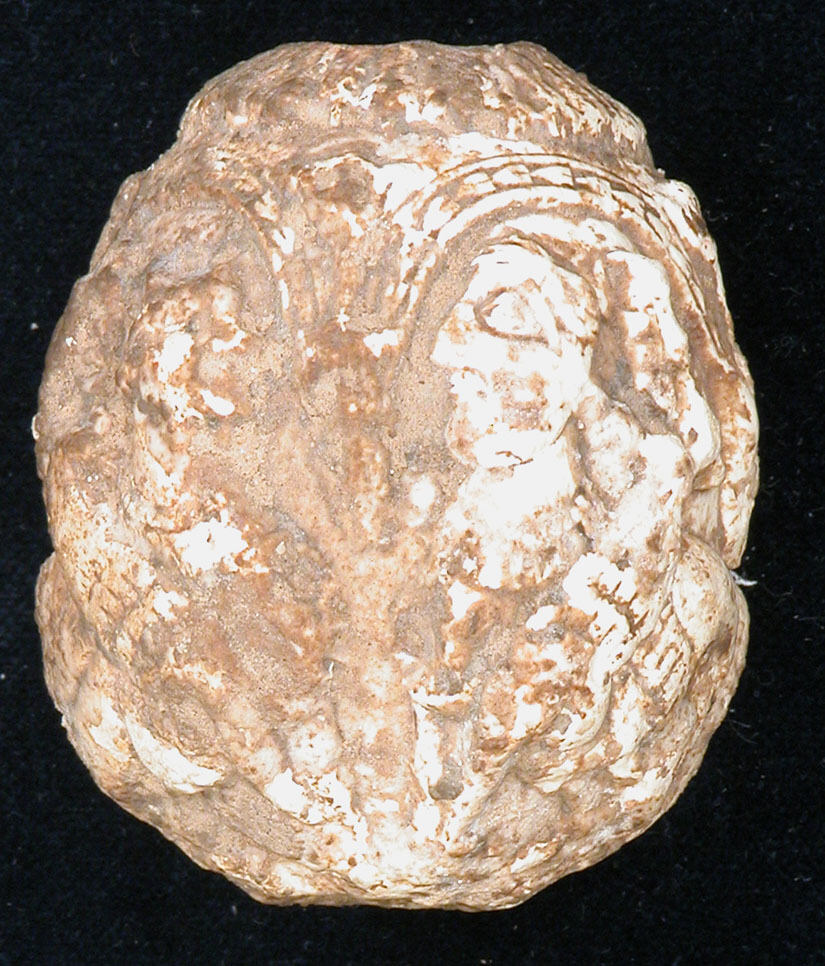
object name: mace head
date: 901-1100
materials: stone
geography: iran